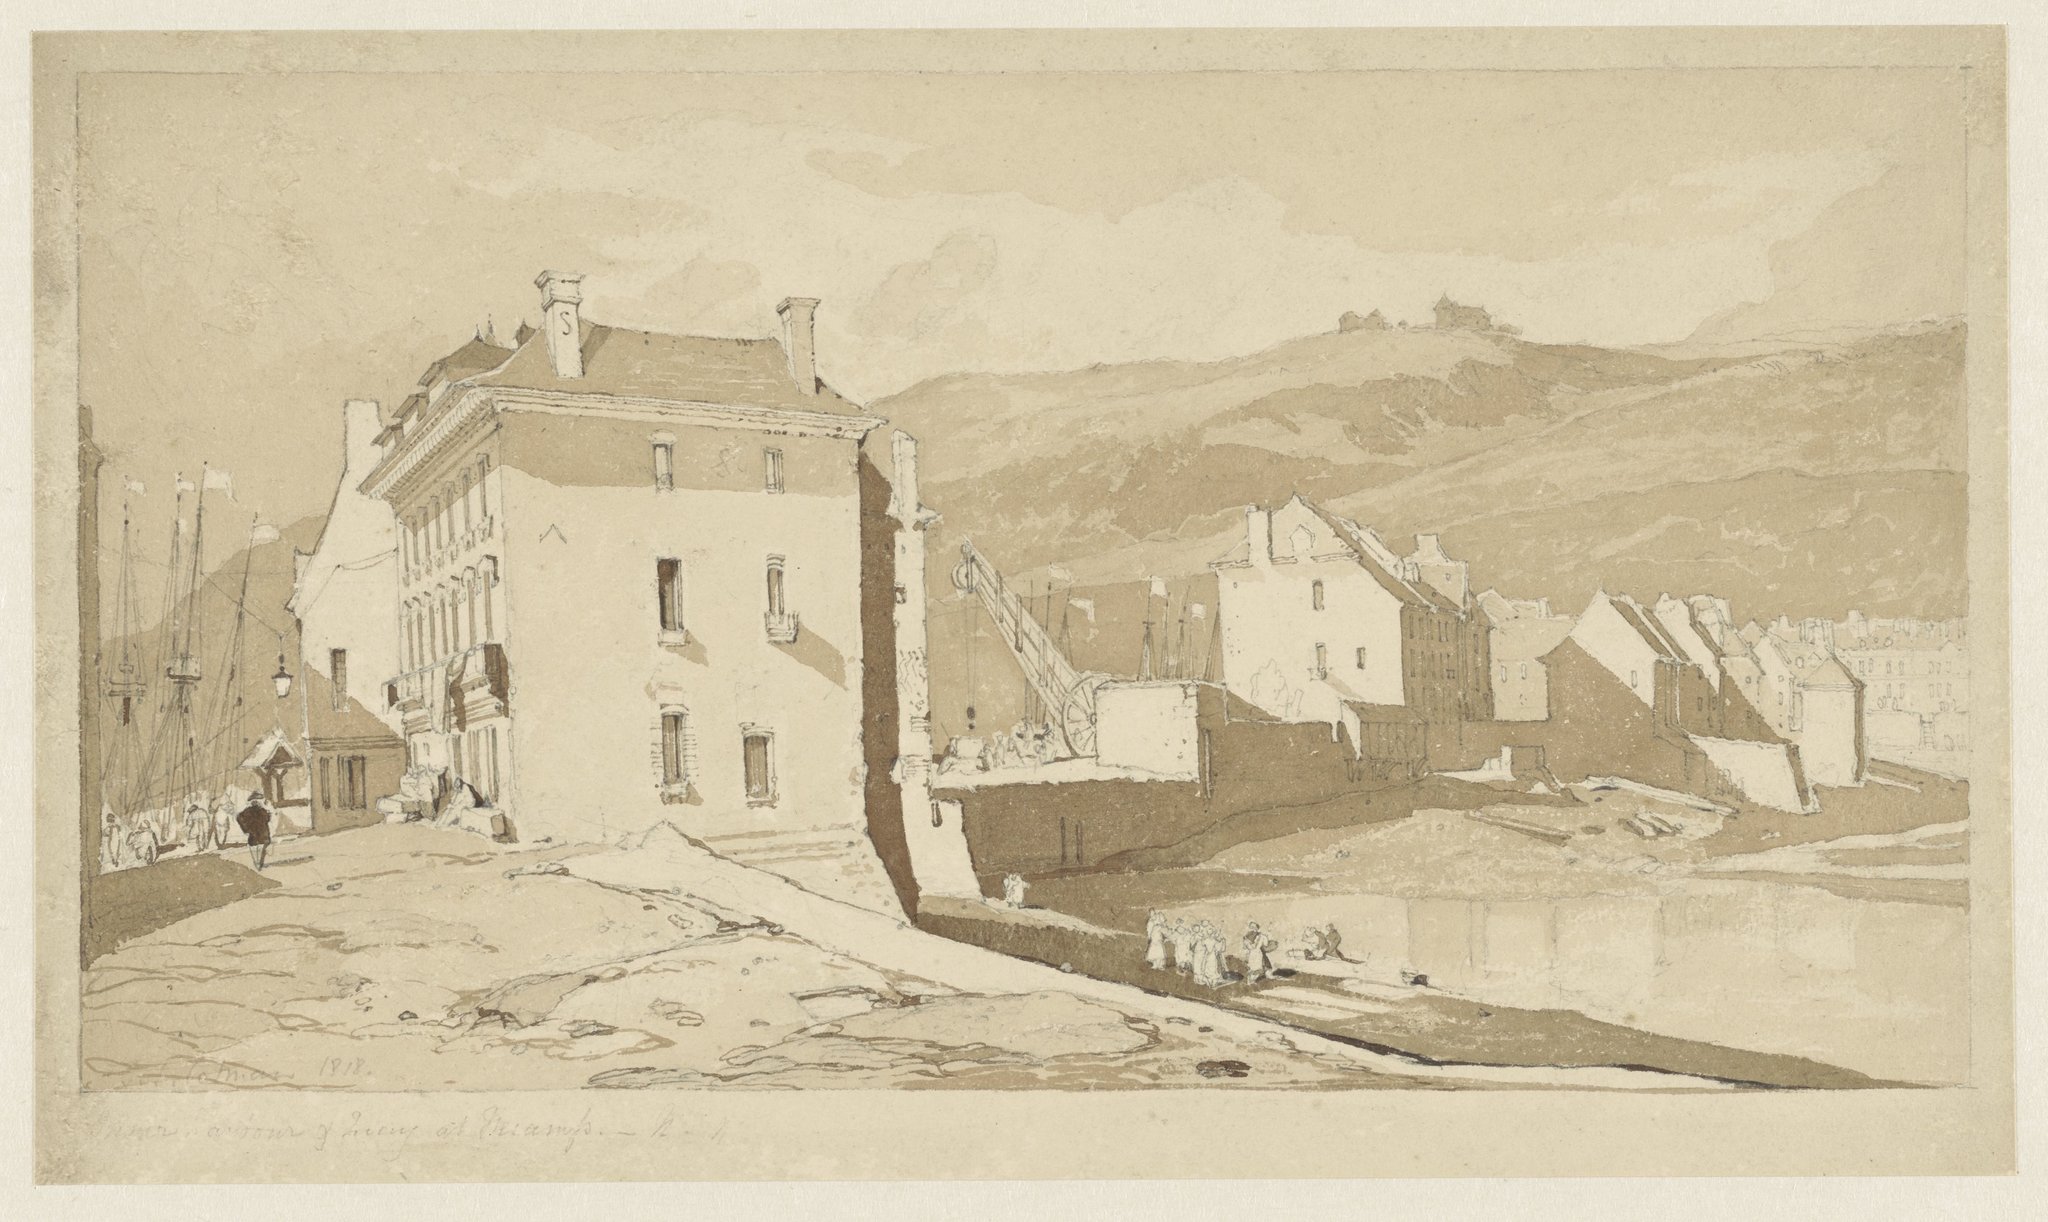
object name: drawing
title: Binnenhaven en kade te Fécamp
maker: john sell cotman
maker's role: draughtsman, print maker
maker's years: 1782-1842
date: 1818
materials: paper, pencil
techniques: brush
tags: quay (+ city(-scape) with figures, staffage)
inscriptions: inscription: ‘Inner [?] harbour and quauy at Fécamp’